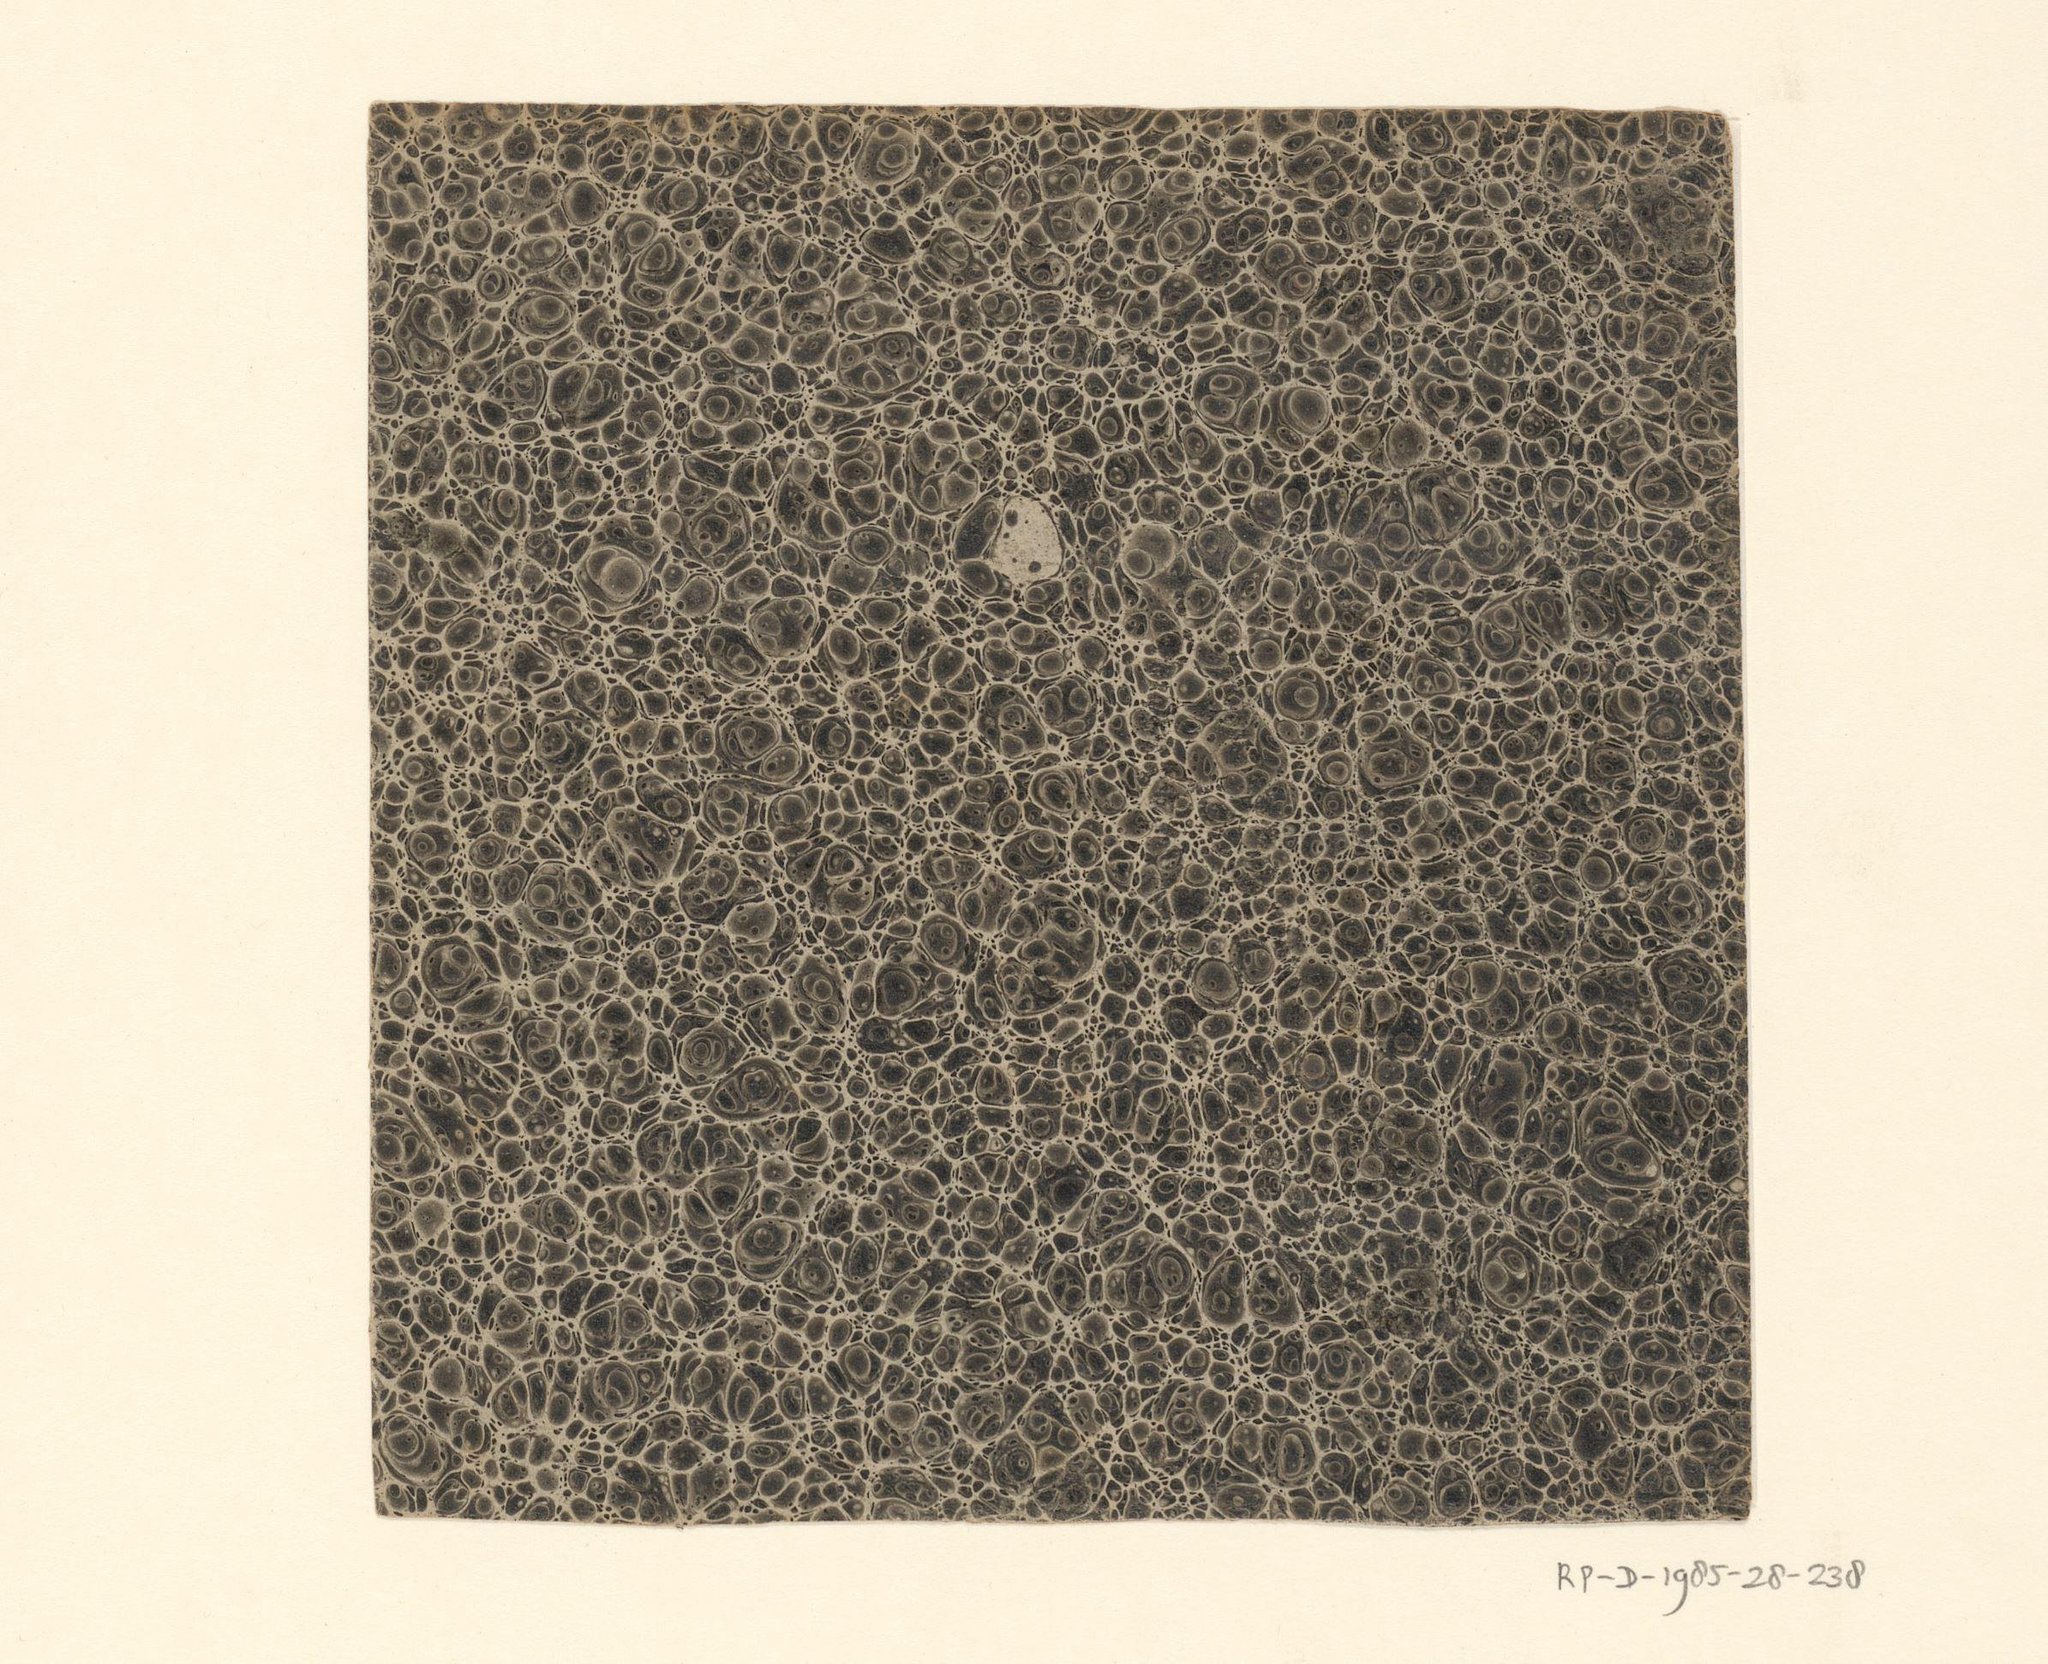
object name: marbled paper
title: Ringkiezelmarmer in bruin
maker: Anonymous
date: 1700-1950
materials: paint, paper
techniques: marbled paper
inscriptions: collector's mark: Lugt 2228, collector's mark: Lugt 2760